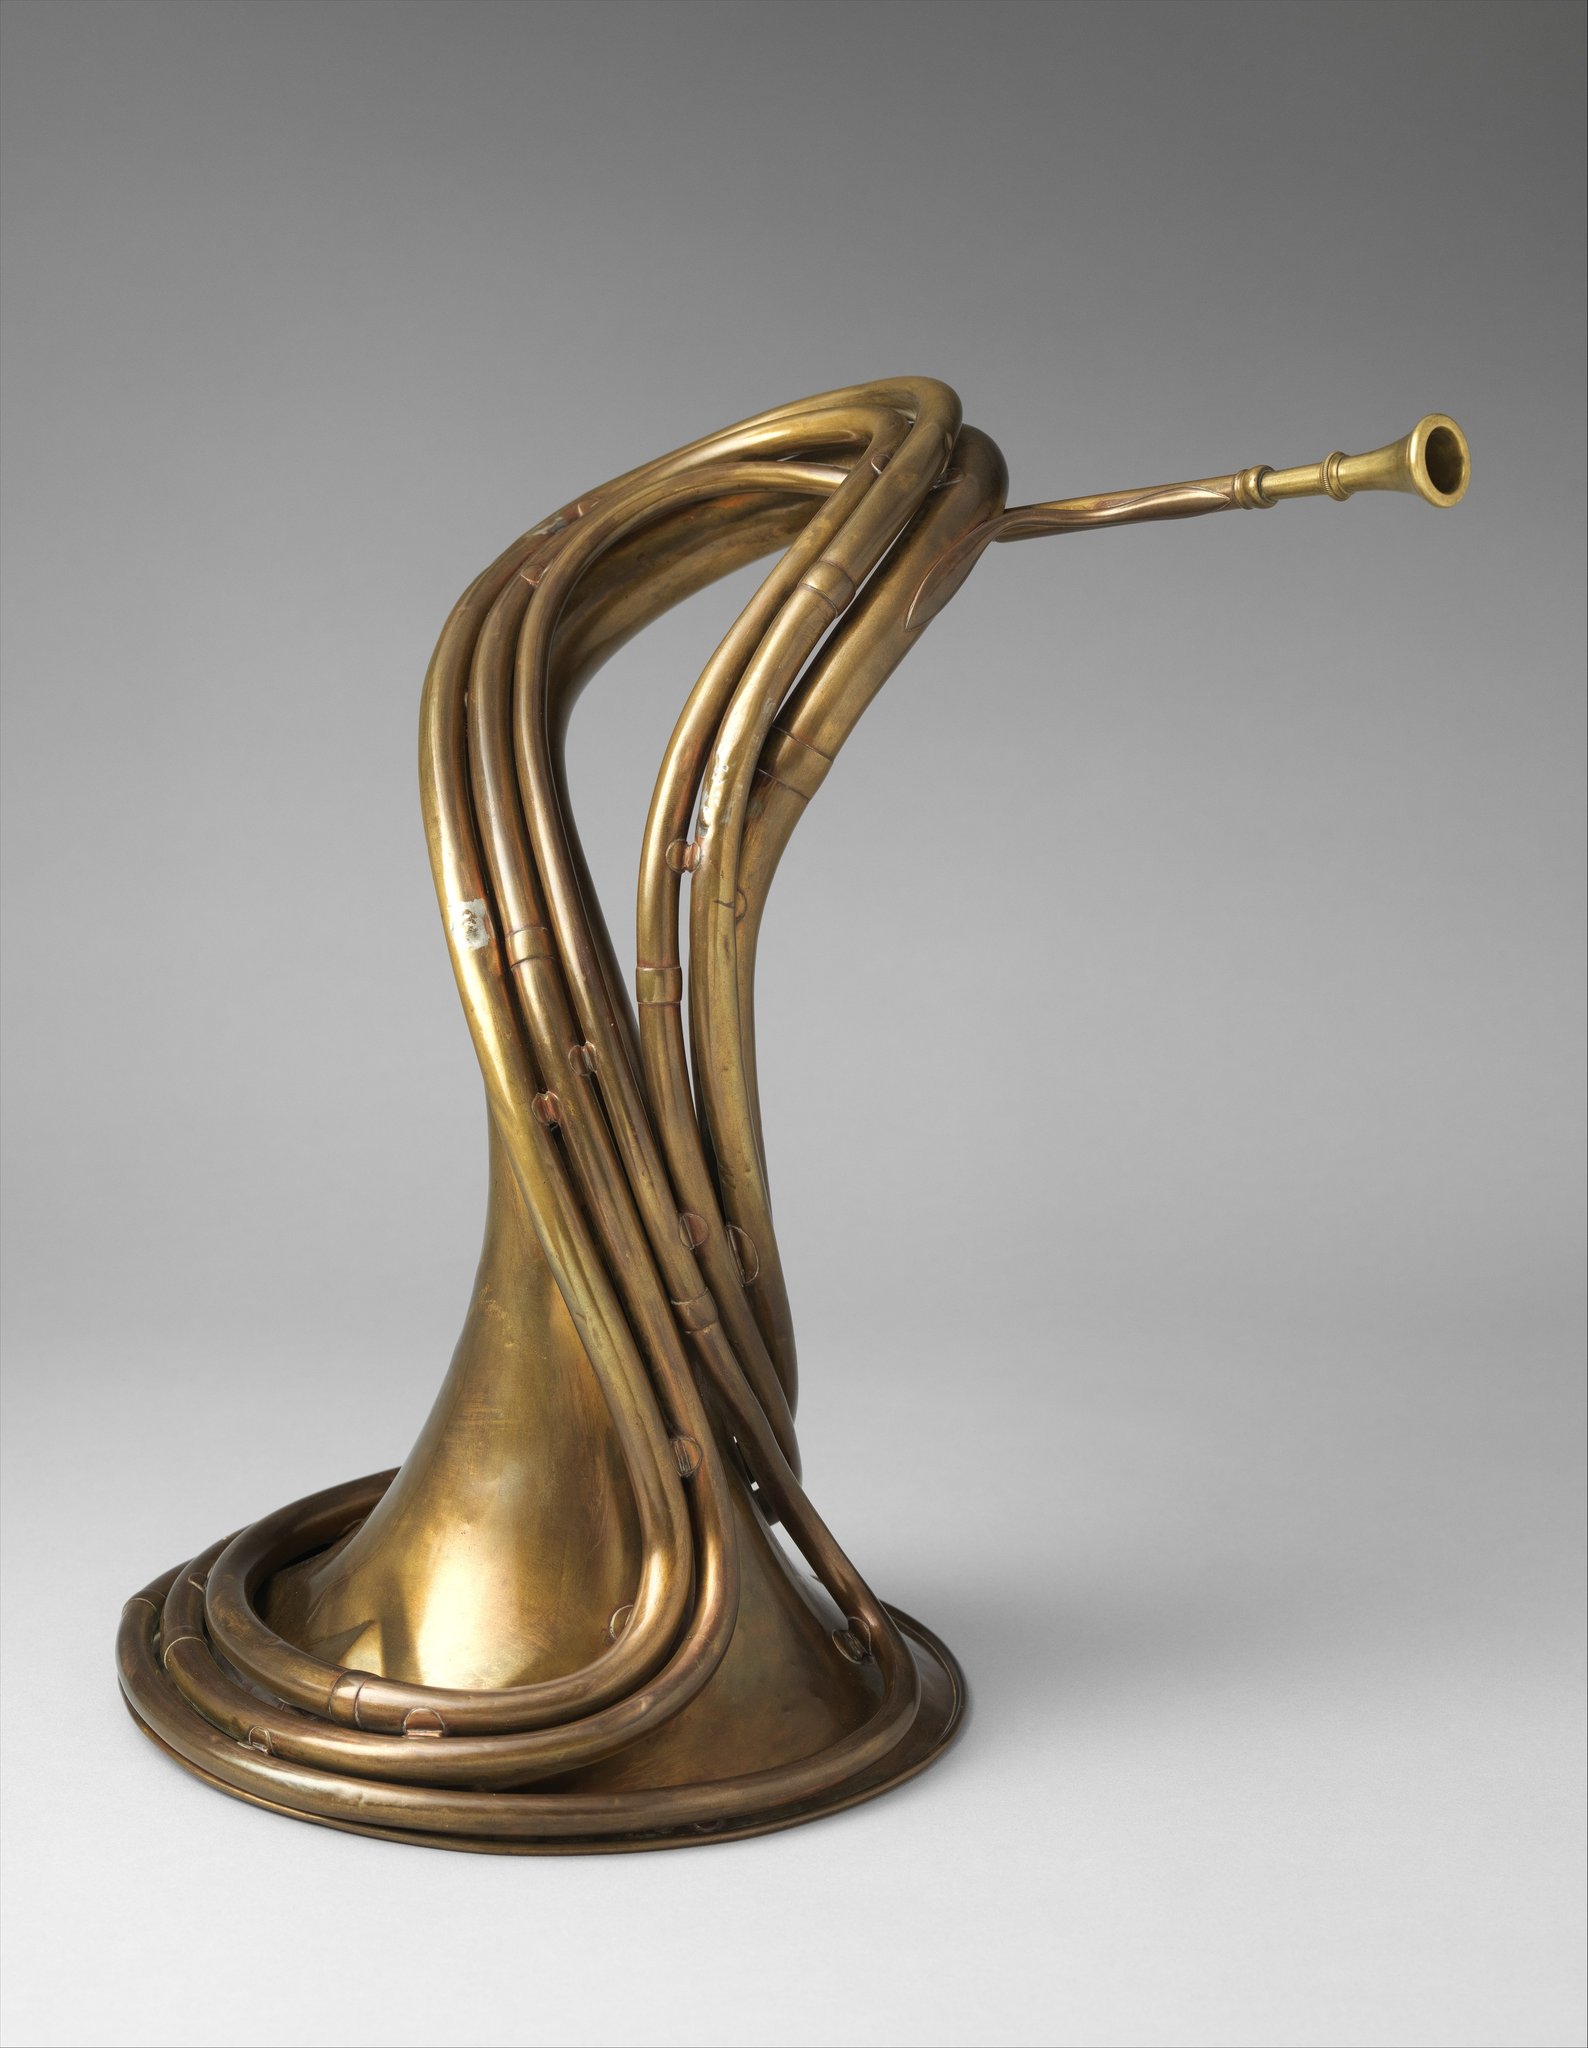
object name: cornet trompe in d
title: Cornet-trompe in D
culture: french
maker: alphonse (antoine) sax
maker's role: maker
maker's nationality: belgian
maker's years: 1822-1874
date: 1862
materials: brass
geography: france